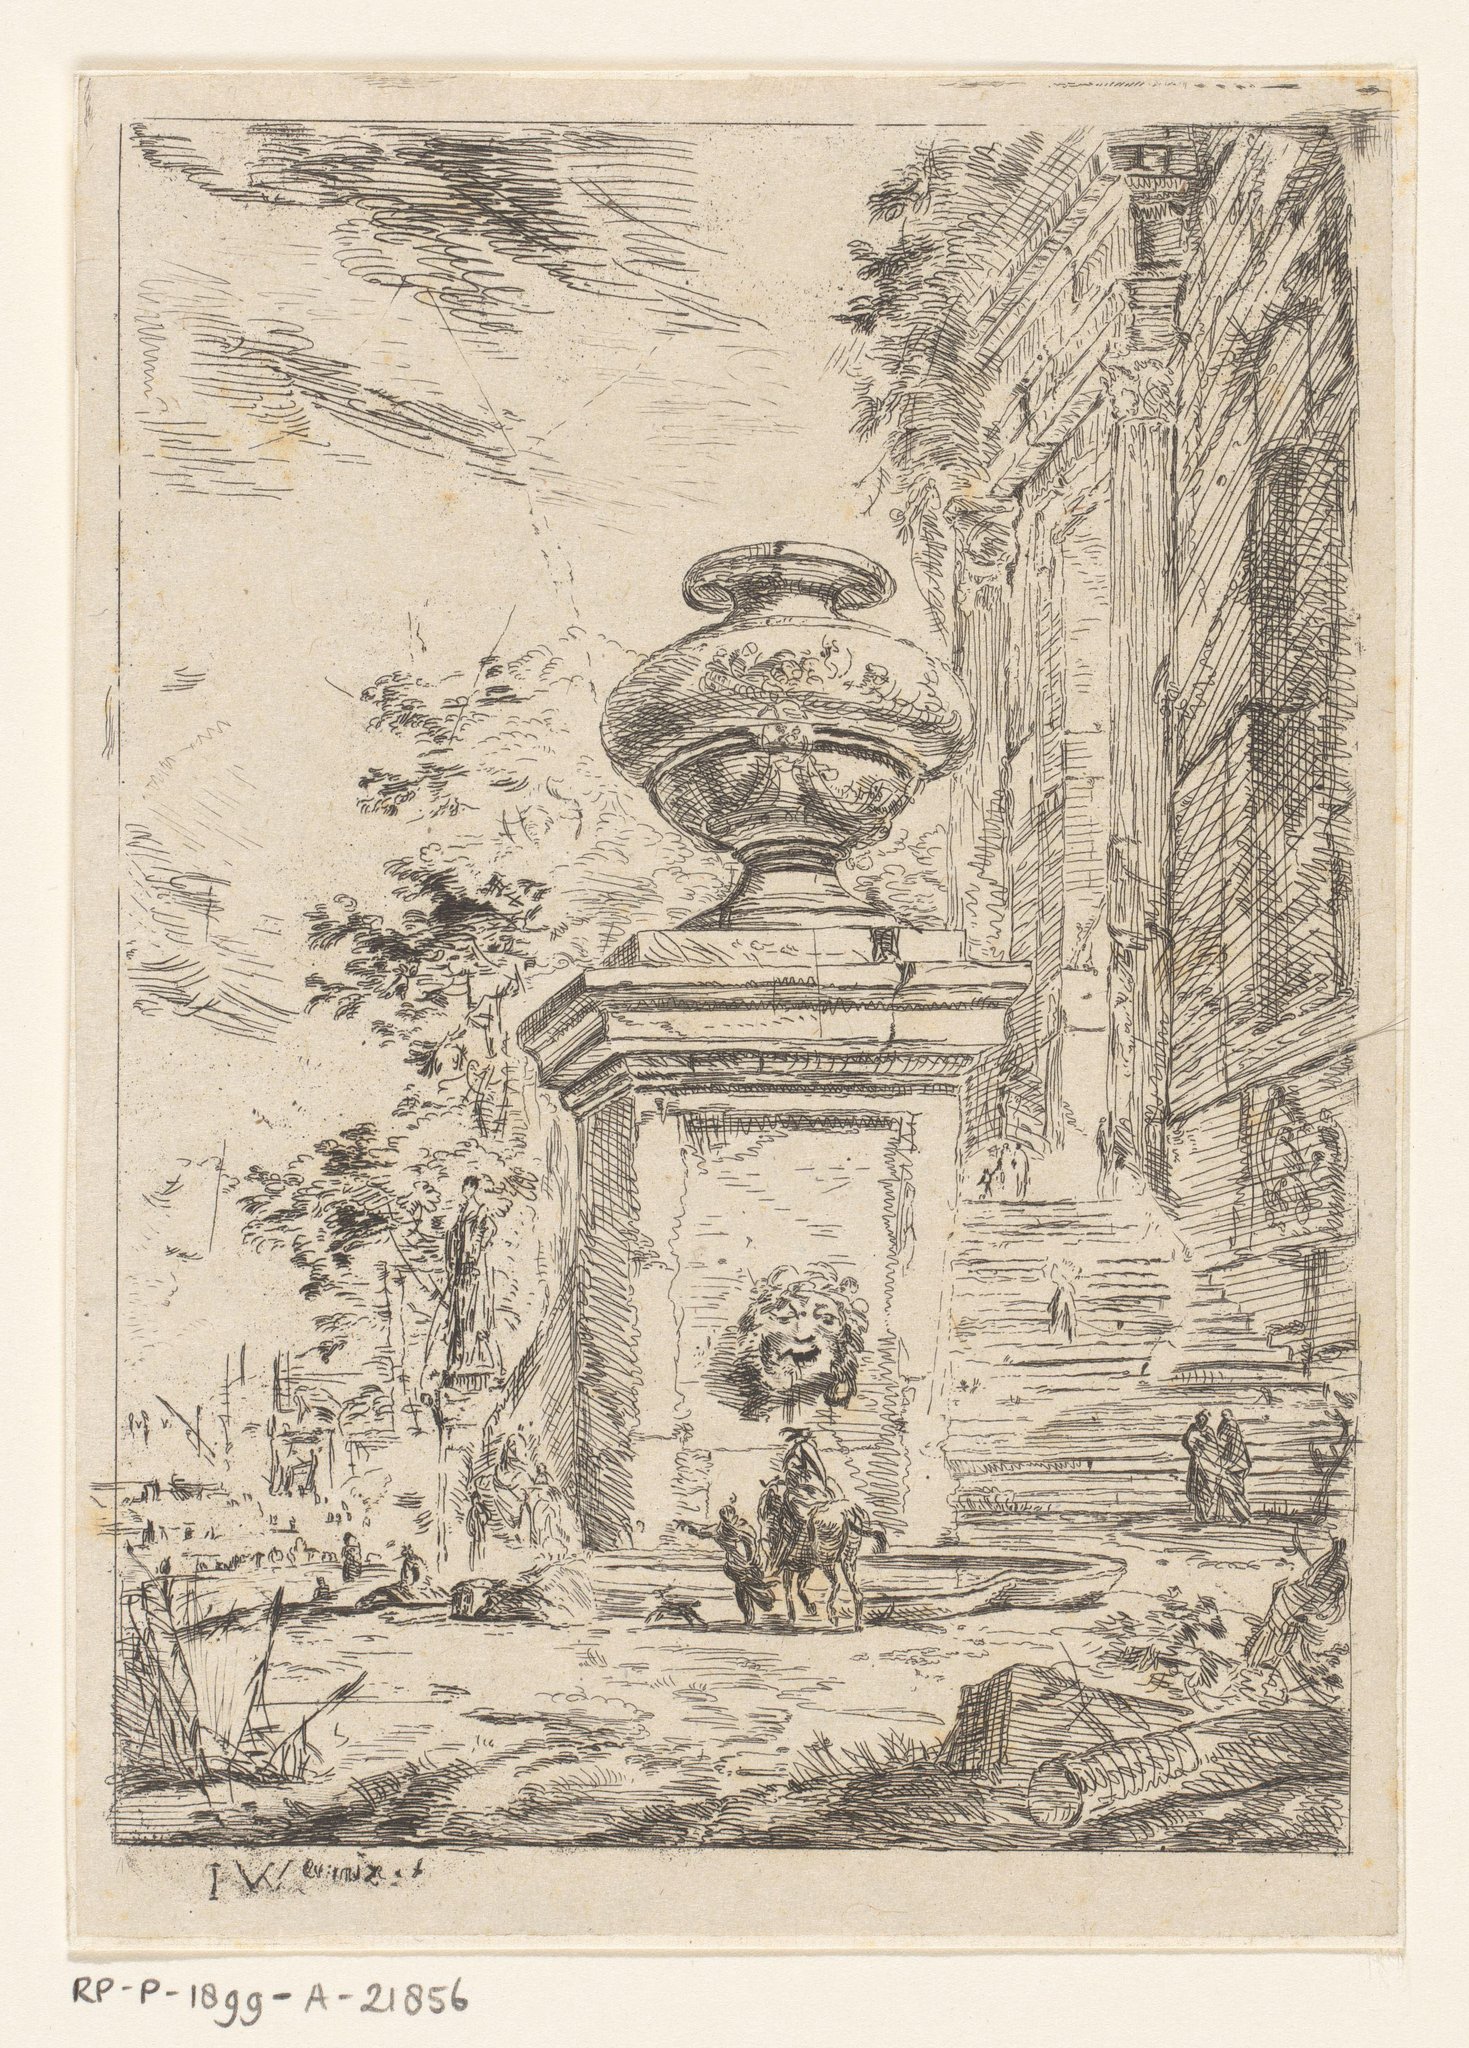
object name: print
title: Fontein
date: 1828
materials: paper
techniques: etching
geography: london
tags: riding a horse, ass, or mule; rider, horseman, column, pillar ~ architecture, staircase, ornamental fountain, civic architecture; edifices; dwellings, garden vase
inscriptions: collector's mark: Lugt 2228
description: Prent 37 uit: Ottley, William Young. A collection of thirty-nine facsimiles, rare etchings, by celebrated painters of the Italian, Dutch and Flemish schools. Londen: 1828.